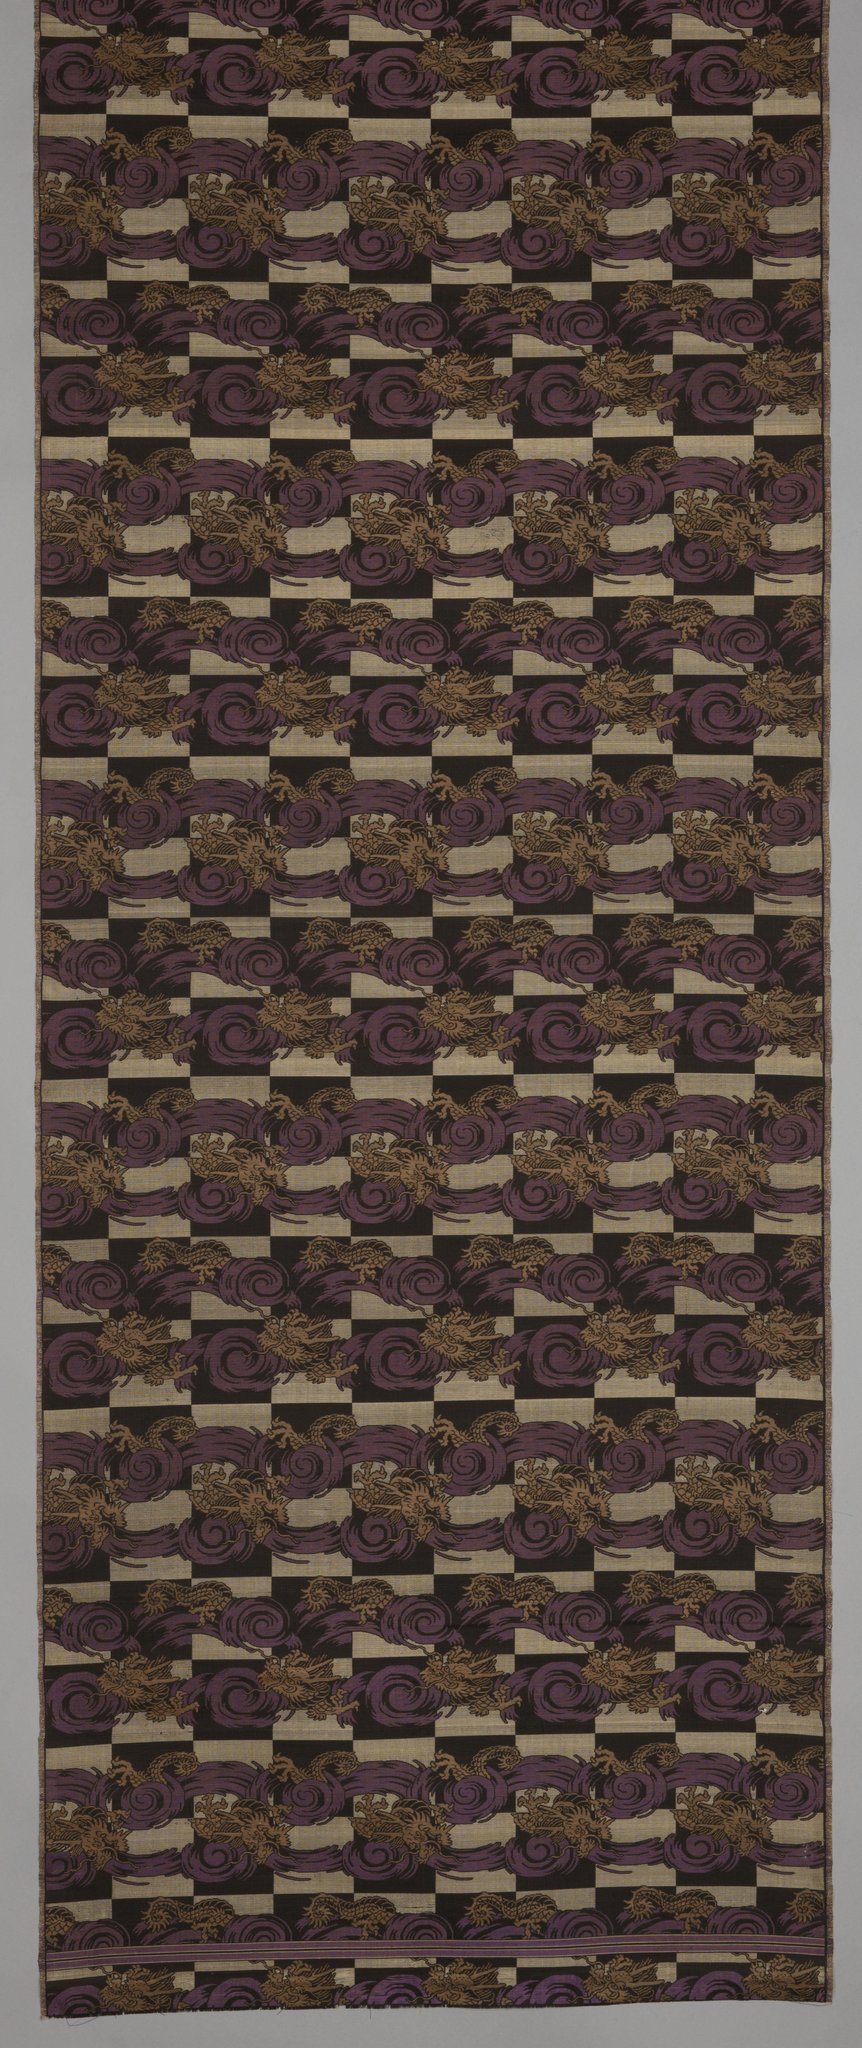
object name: textile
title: Baan zijdedamast met een dessin van paarsgewijs ingeweven banen van golven waartussen drakenkoppen en drakenstaarten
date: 1900-1920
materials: silk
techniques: damask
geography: japan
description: Baan zijdedamast met een dessin van paarsgewijs ingeweven banen van golven waartussen drakenkoppen en drakenstaarten in de kleuren paars, goudbruin en zwart tegen een fond van zilveren en zwarte blokken. Oosterse textiel.